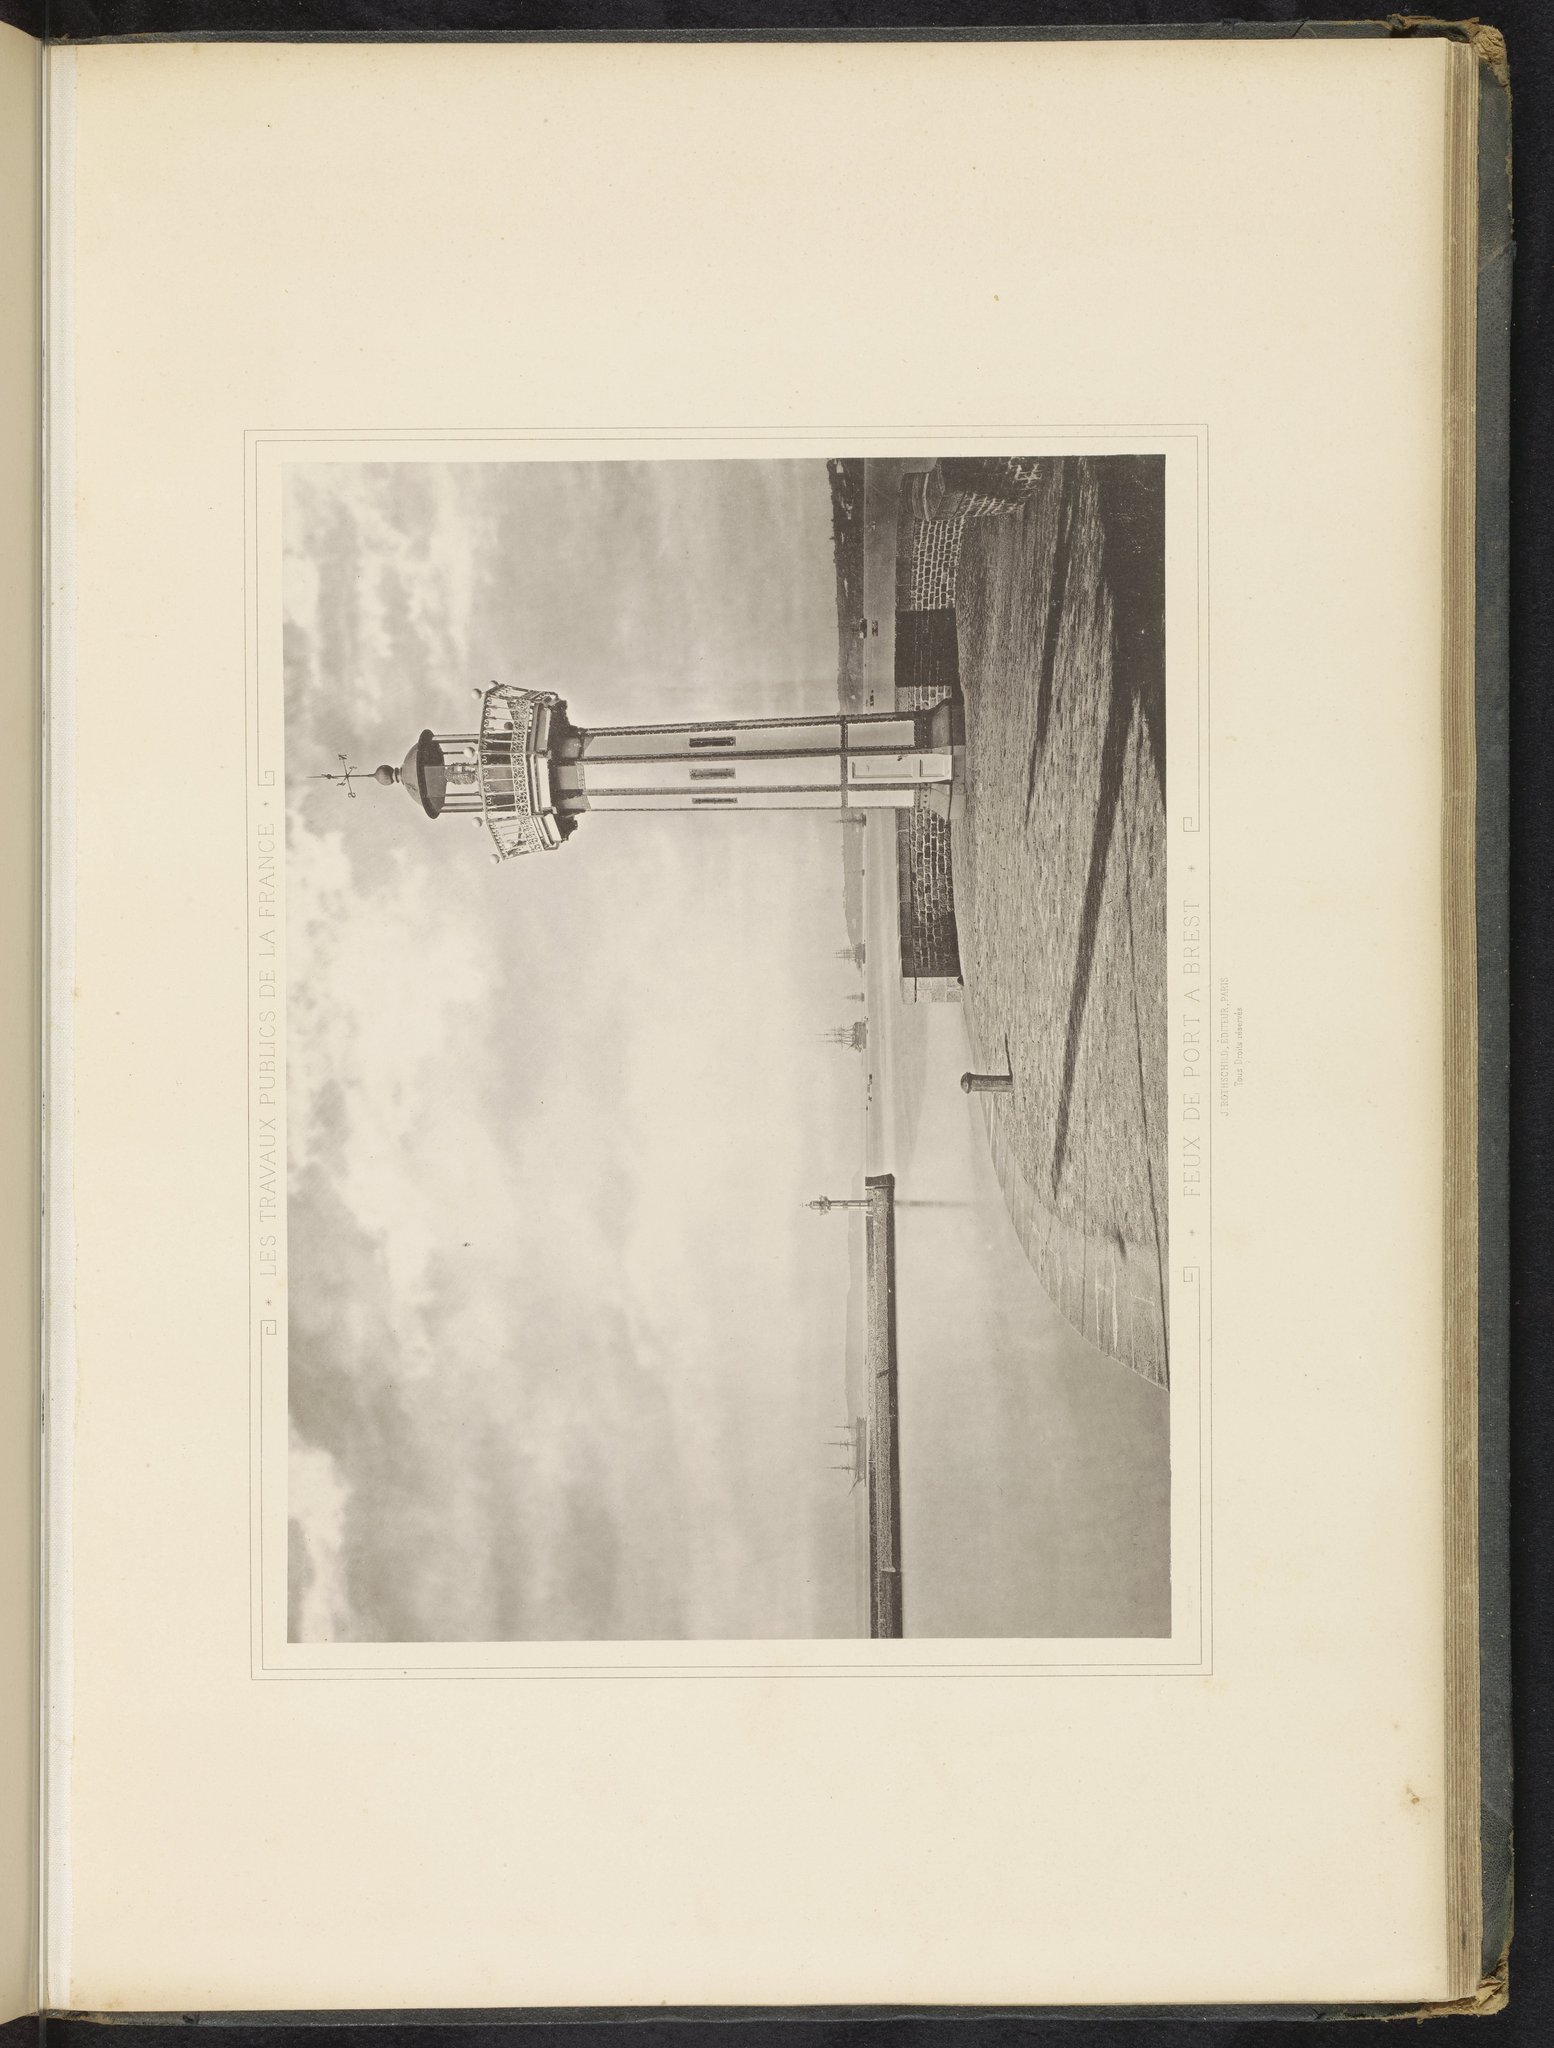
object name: photomechanical print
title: Vuurtoren in de haven van Brest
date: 1873-1883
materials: paper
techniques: photograph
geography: paris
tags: harbour, lighthouse, lightship